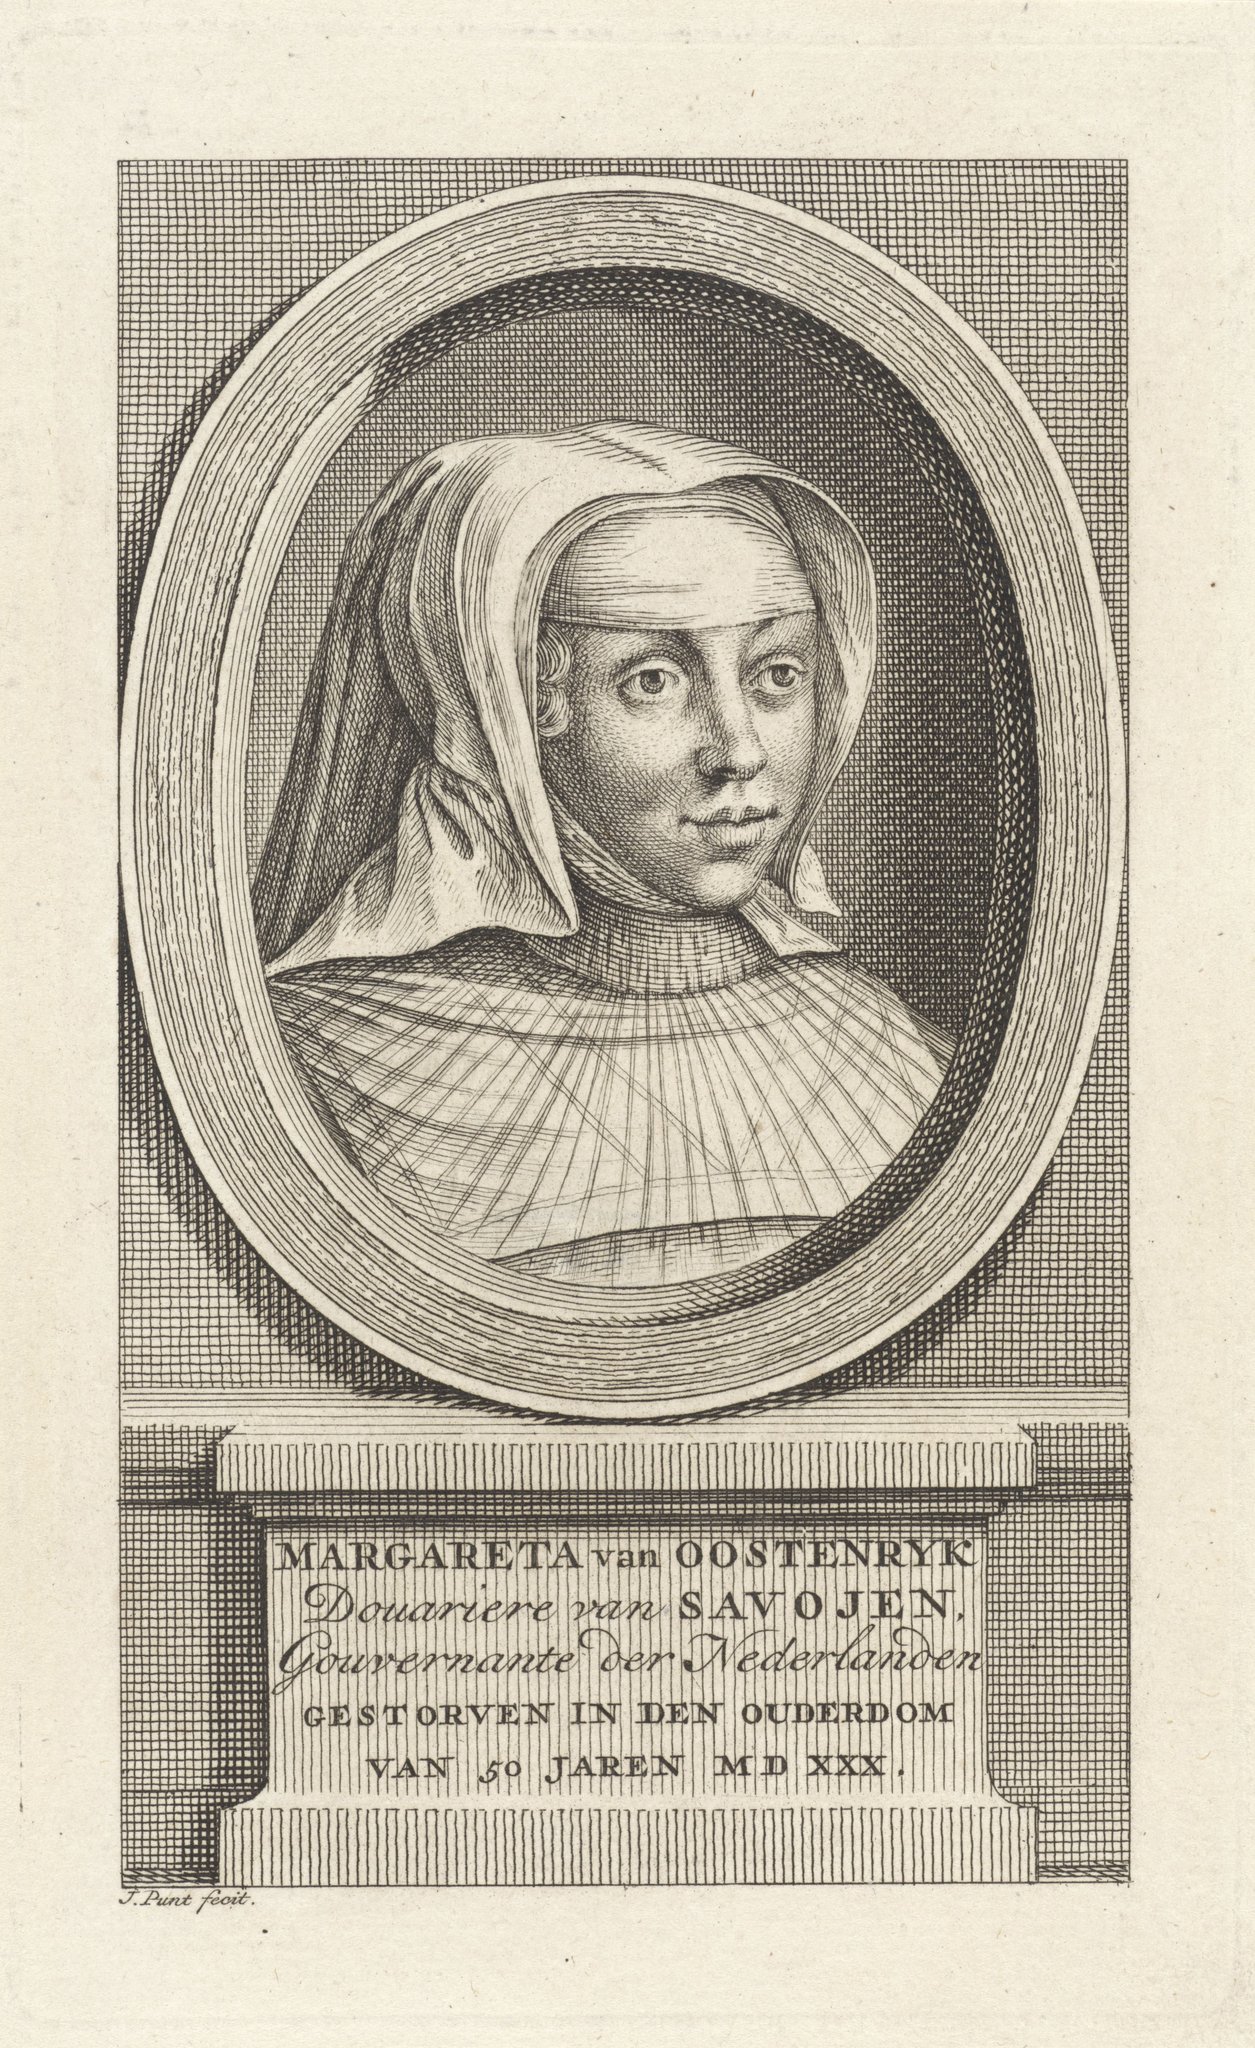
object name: book illustration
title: Portret van Margaretha van Oostenrijk, landvoogdes der Nederlanden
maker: jan punt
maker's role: draughtsman, print maker, publisher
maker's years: 1711-1779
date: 1786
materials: paper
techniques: engraving, etching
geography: northern netherlands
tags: brussels, mechelen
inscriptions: collector's mark: Lugt 2228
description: Prent gebruikt als illustratie in: Meteren, Emanuel van. Oorlogen en geschiedenissen der Nederlanderen en derzelver nabuuren, deel I, p. 75. Amsterdam: Steven Jacobus Baalde, 1786.